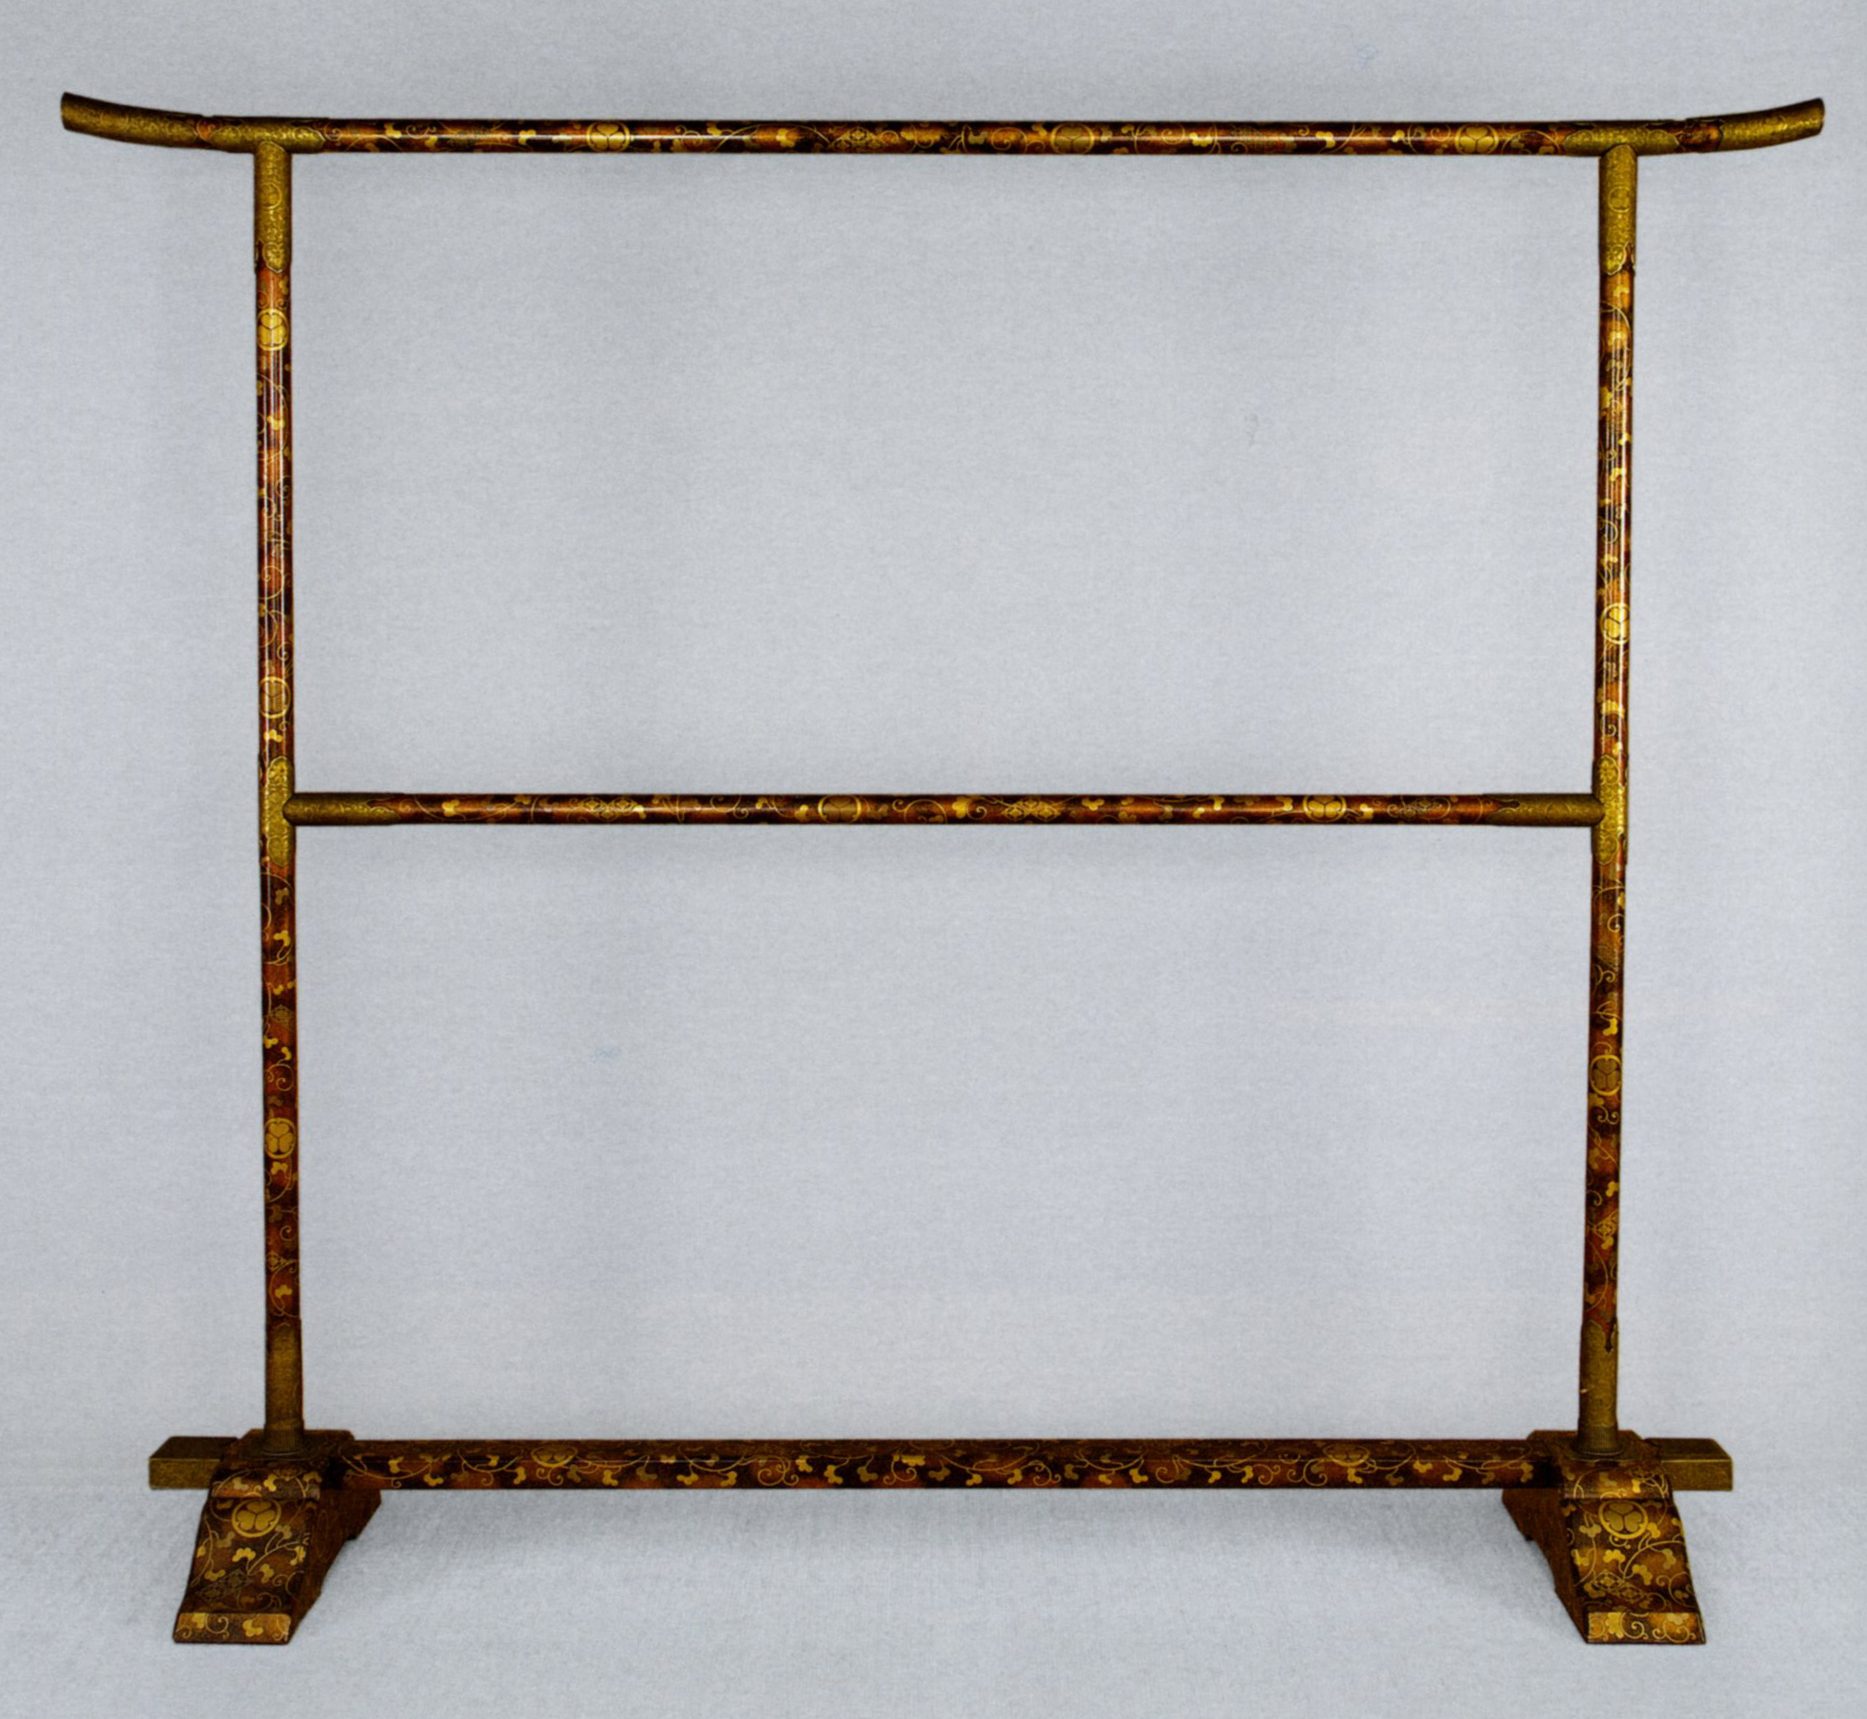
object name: robe stand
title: Kimono Rack (Ikō) with Scrolling Foliage and Tokugawa Family Crest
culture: japanese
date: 1701-1800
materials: gilt bronze, gold, wood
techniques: hiramakie, lacquer